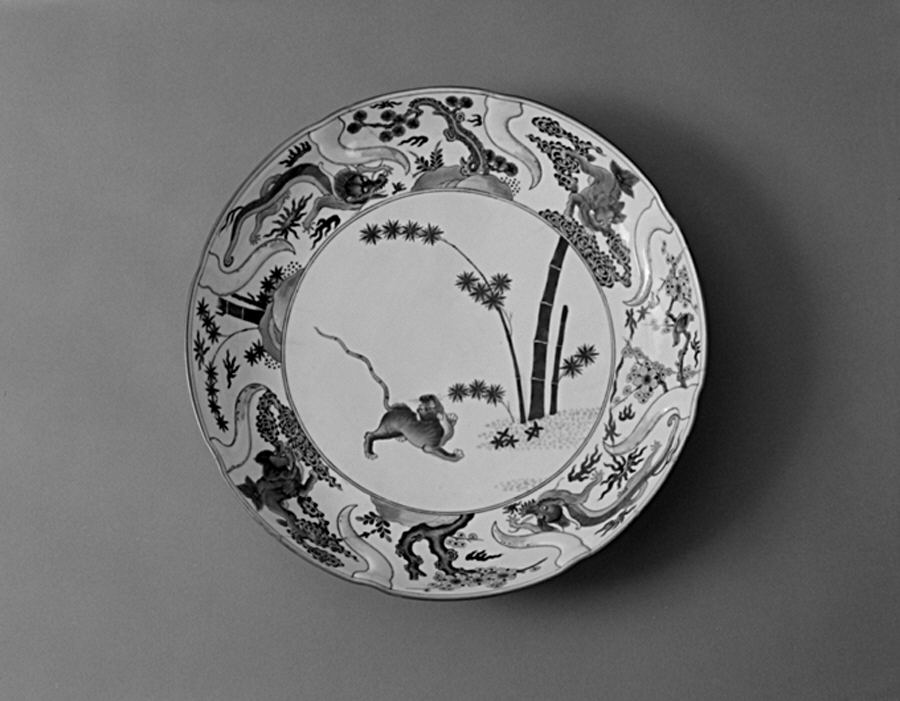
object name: plate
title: Plate with Molded Rim and Decoration of Kakiemon-Style Tiger and Bamboo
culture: chinese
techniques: underglaze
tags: tigers,bamboo